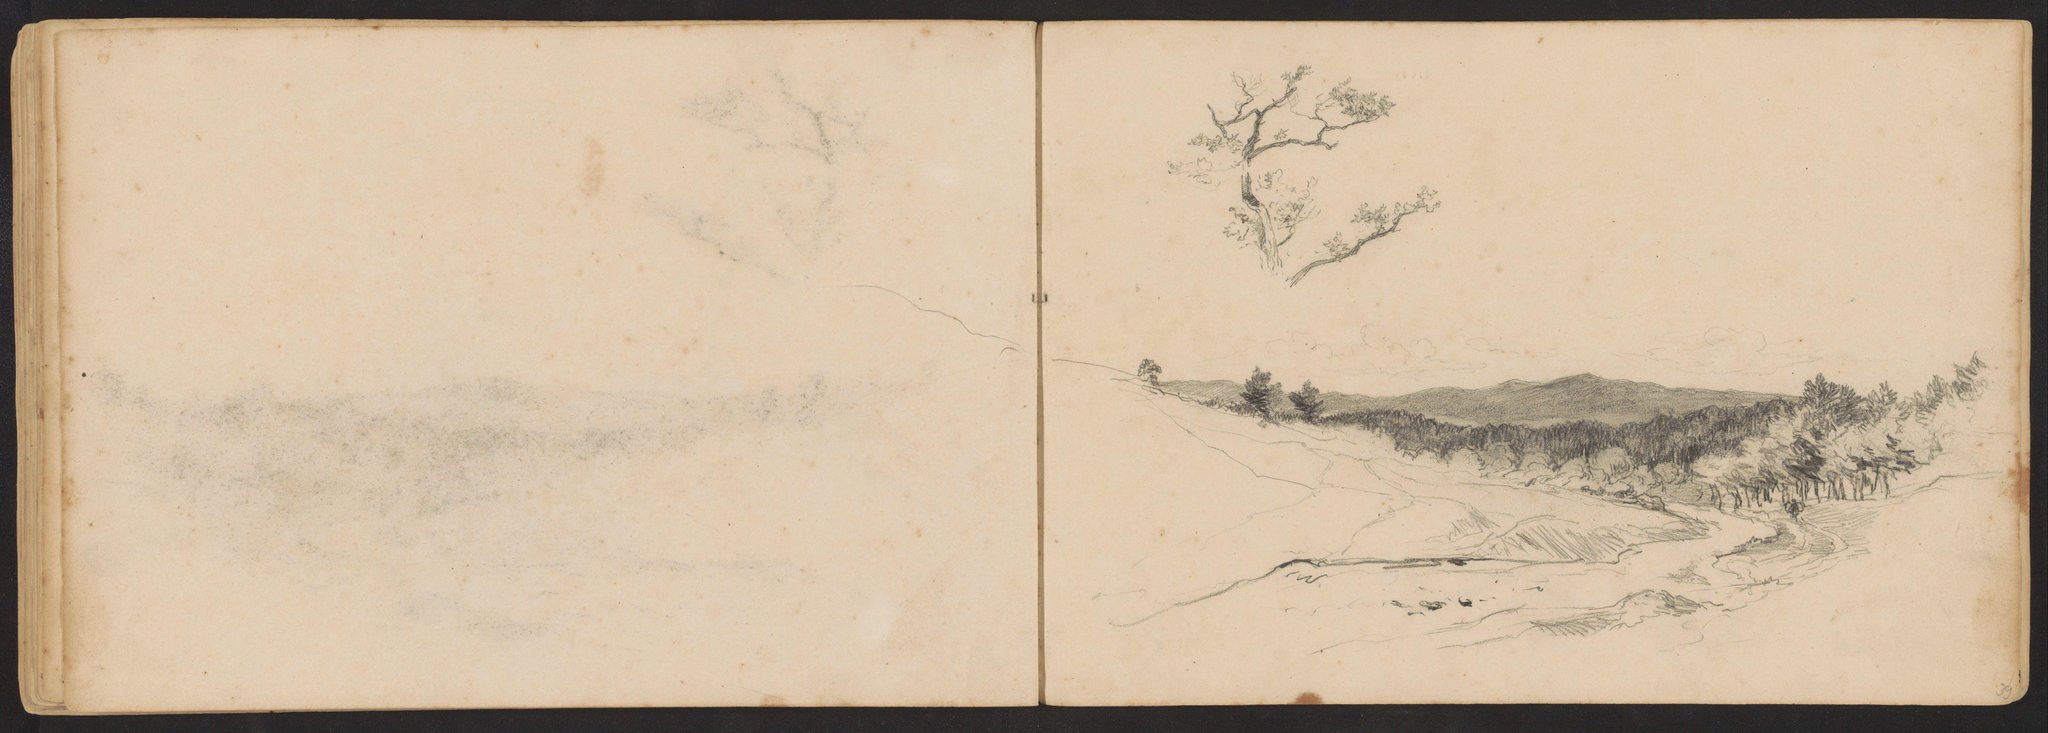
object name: sketchbook leaf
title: Boomtop en een figuur op een pad in een heidelandschap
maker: johannes tavenraat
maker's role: draughtsman, painter, print maker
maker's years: 1809-1881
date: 1842-1868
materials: paper, pencil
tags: low hill country, trees, road, path, landscapes (+ landscape with figures, staffage)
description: Blad 39 recto in een schetsboek met 45 bladen.